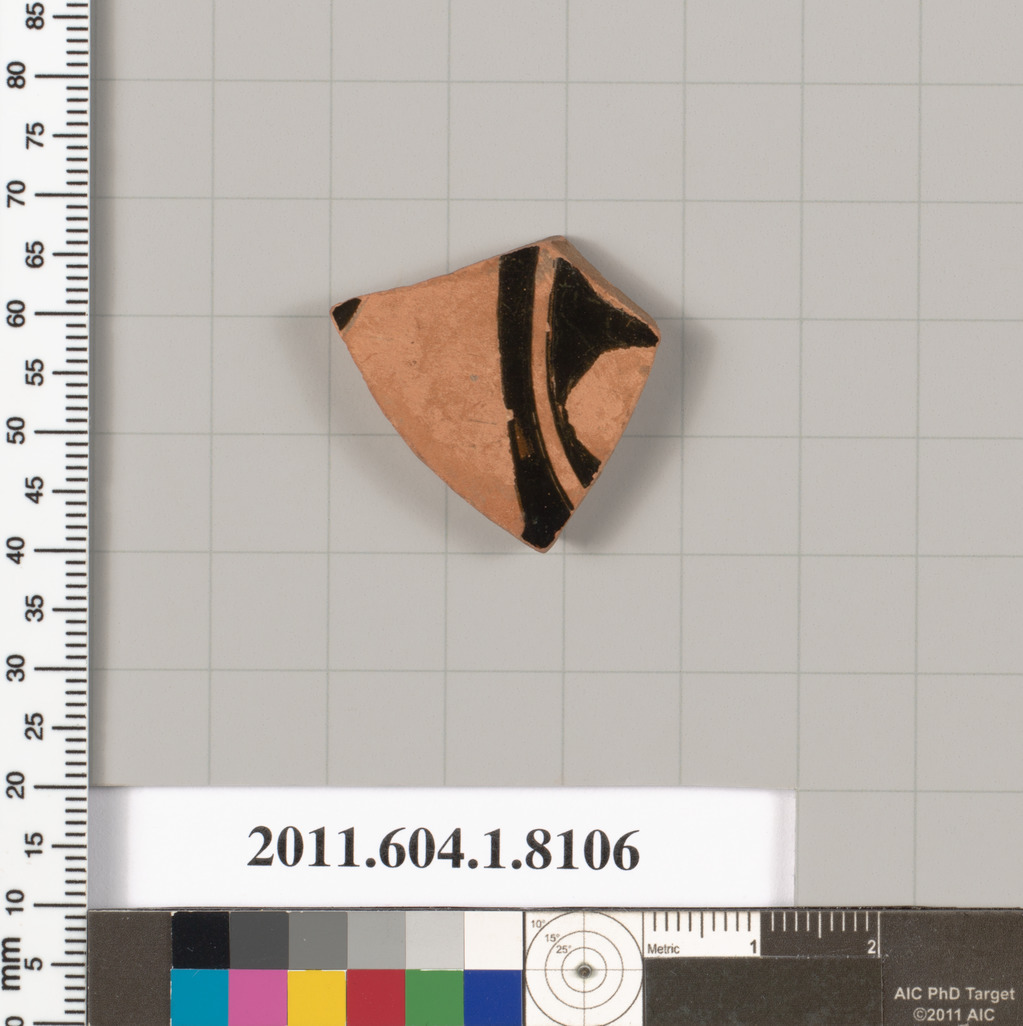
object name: kylix fragment, eye cup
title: Terracotta rim fragment of a kylix: eye-cup (drinking cup)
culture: greek, attic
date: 520-510 BCE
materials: terracotta